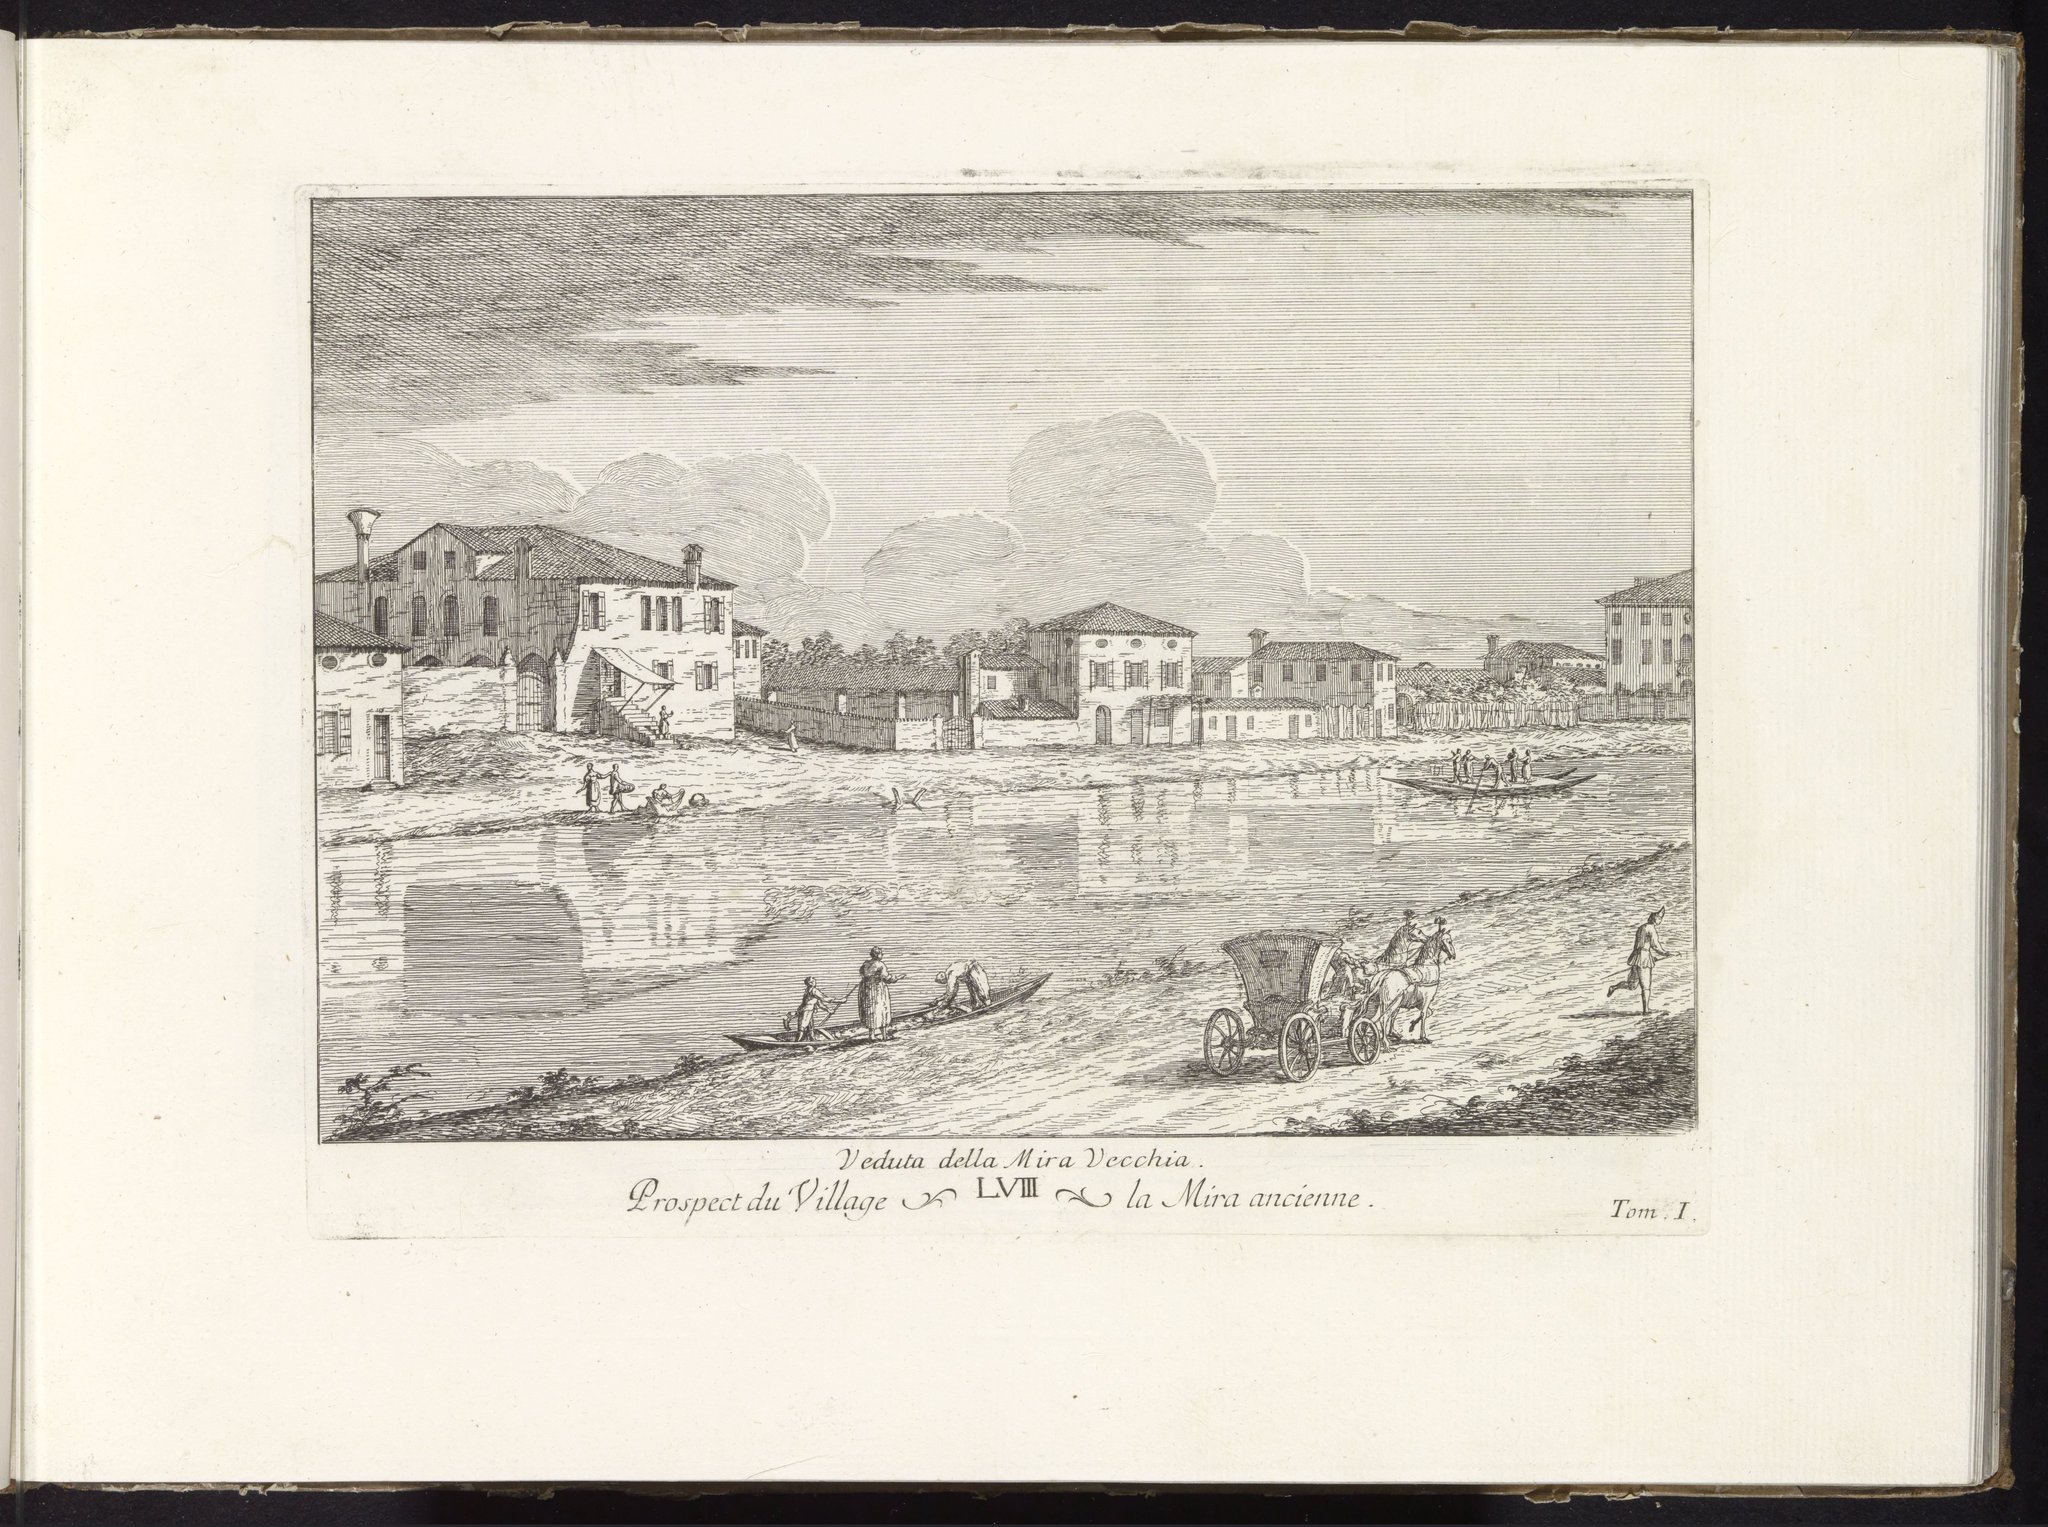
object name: print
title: Veduta della Mira Vecchi (...)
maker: giovanni francesco costa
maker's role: draughtsman, painter, print maker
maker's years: -1773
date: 1750-1760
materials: paper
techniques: etching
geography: venice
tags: river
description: Gezicht op Mira Vecchia waar de rivier de Brenta doorheen stroomt. Genummerd midden onder: LVIII en rechtsonder: Tom: I. Deze prent maakt deel uit van een album.